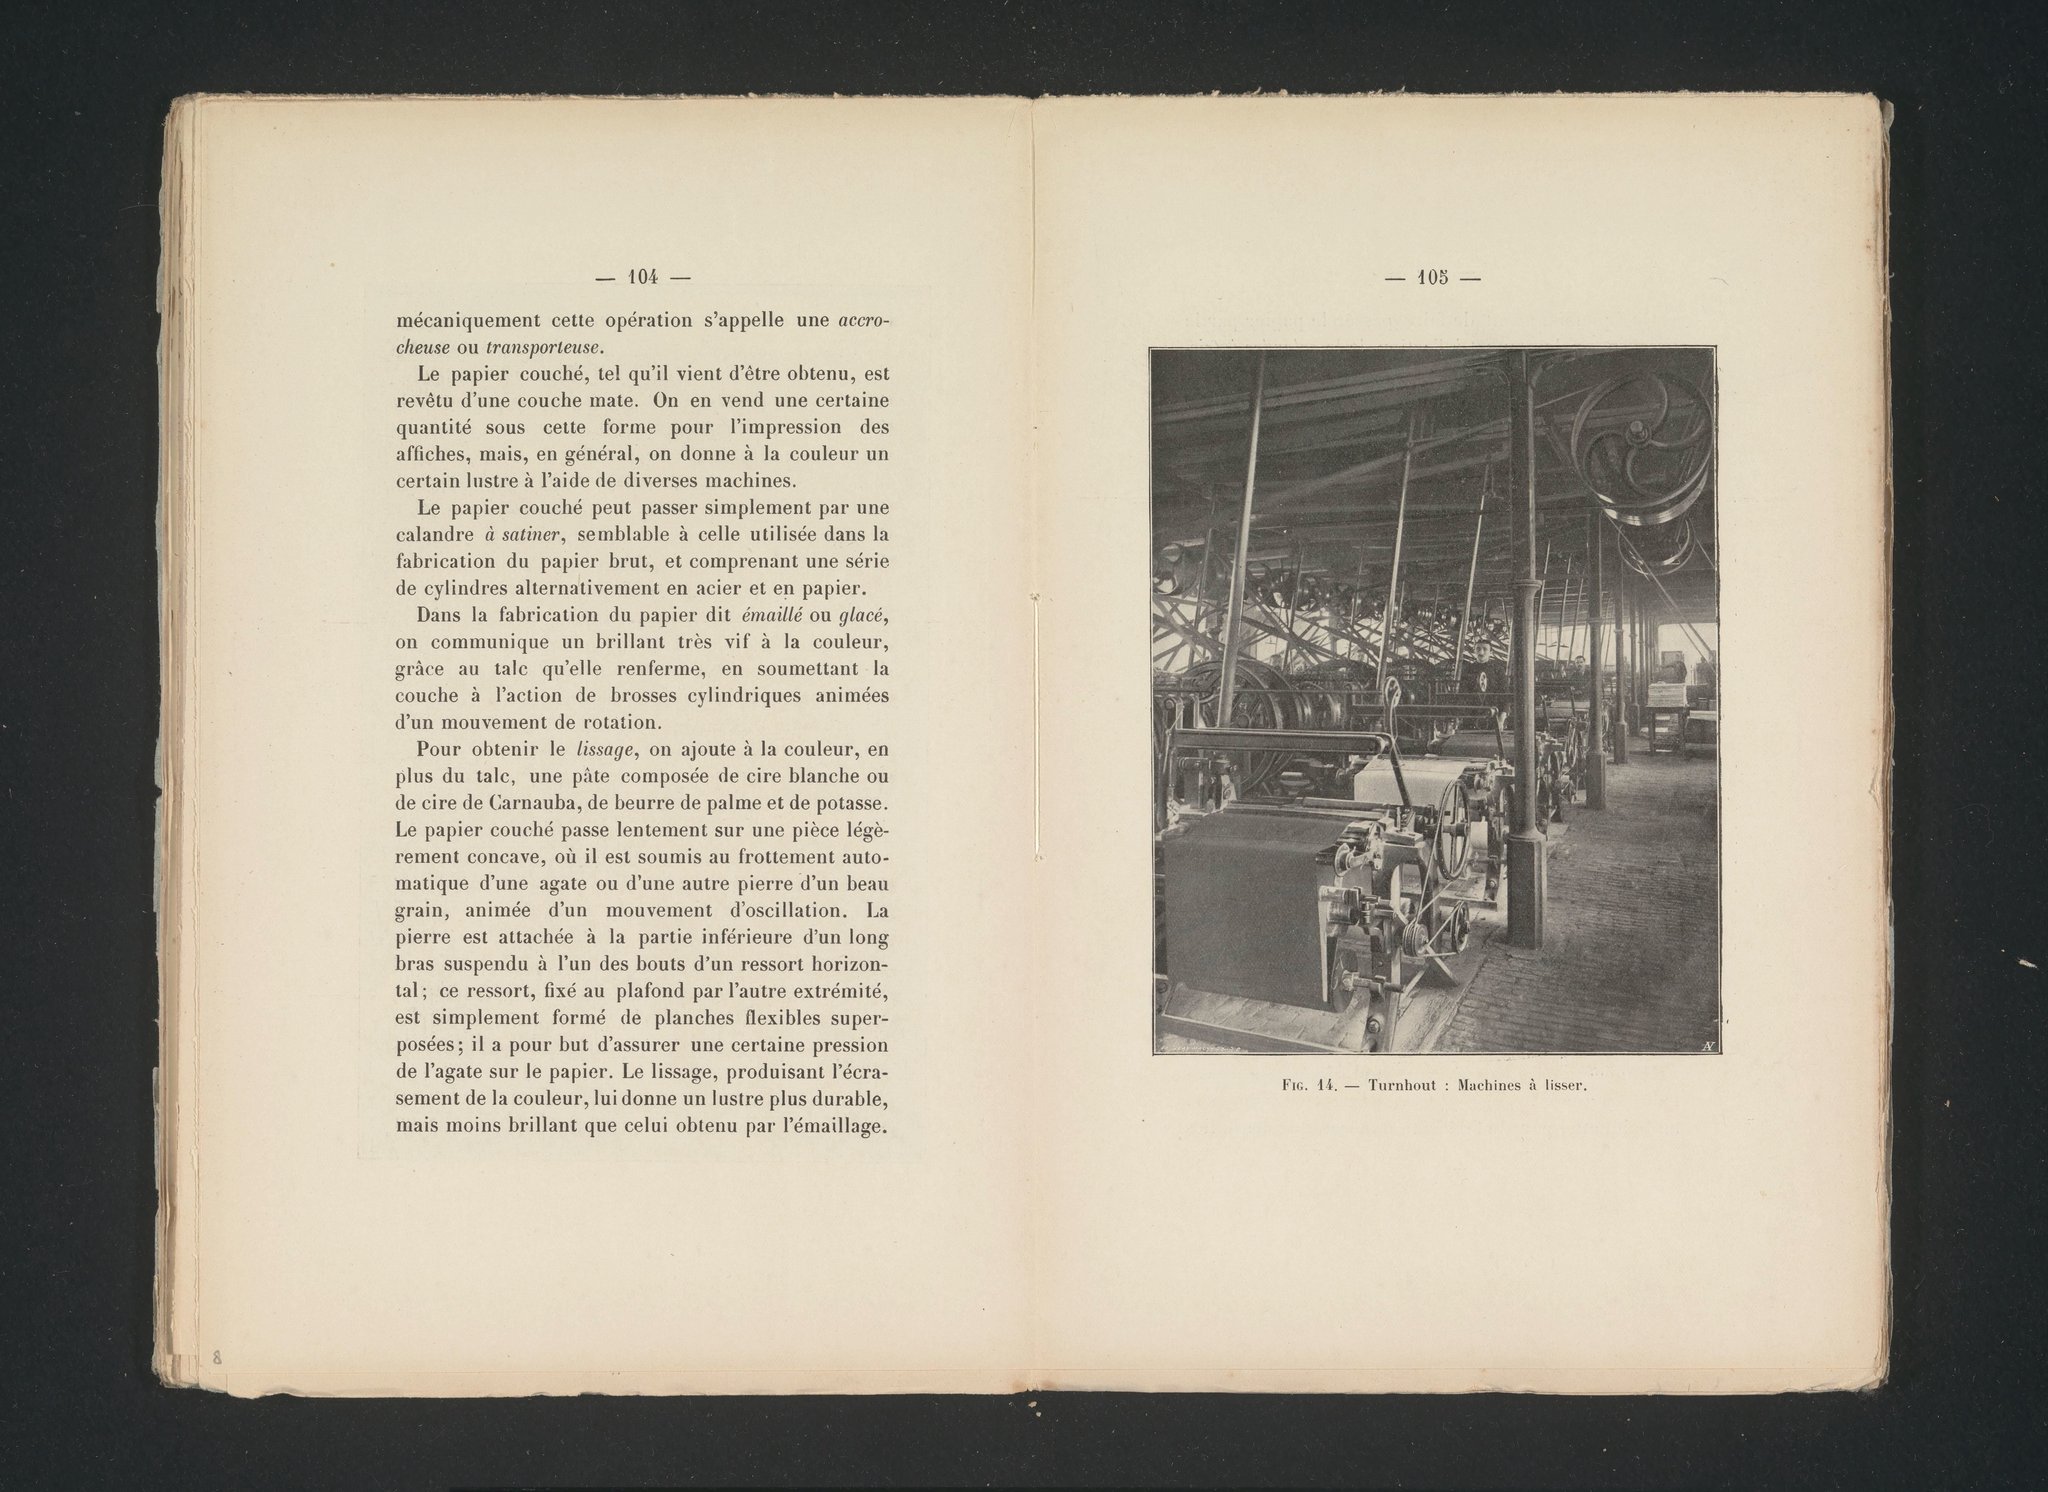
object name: photomechanical print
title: Gezicht op een werkplaats met machines om papier glad te maken in een papierfabriek in Turnhout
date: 1901-1906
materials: paper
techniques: autotype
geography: turnhout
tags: machine driven by electricity, paper (writing material), workshop-interior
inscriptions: monogram: ‘AN’, inscription: ‘Fig. 14. - Turnhout: Machines à lisser.’